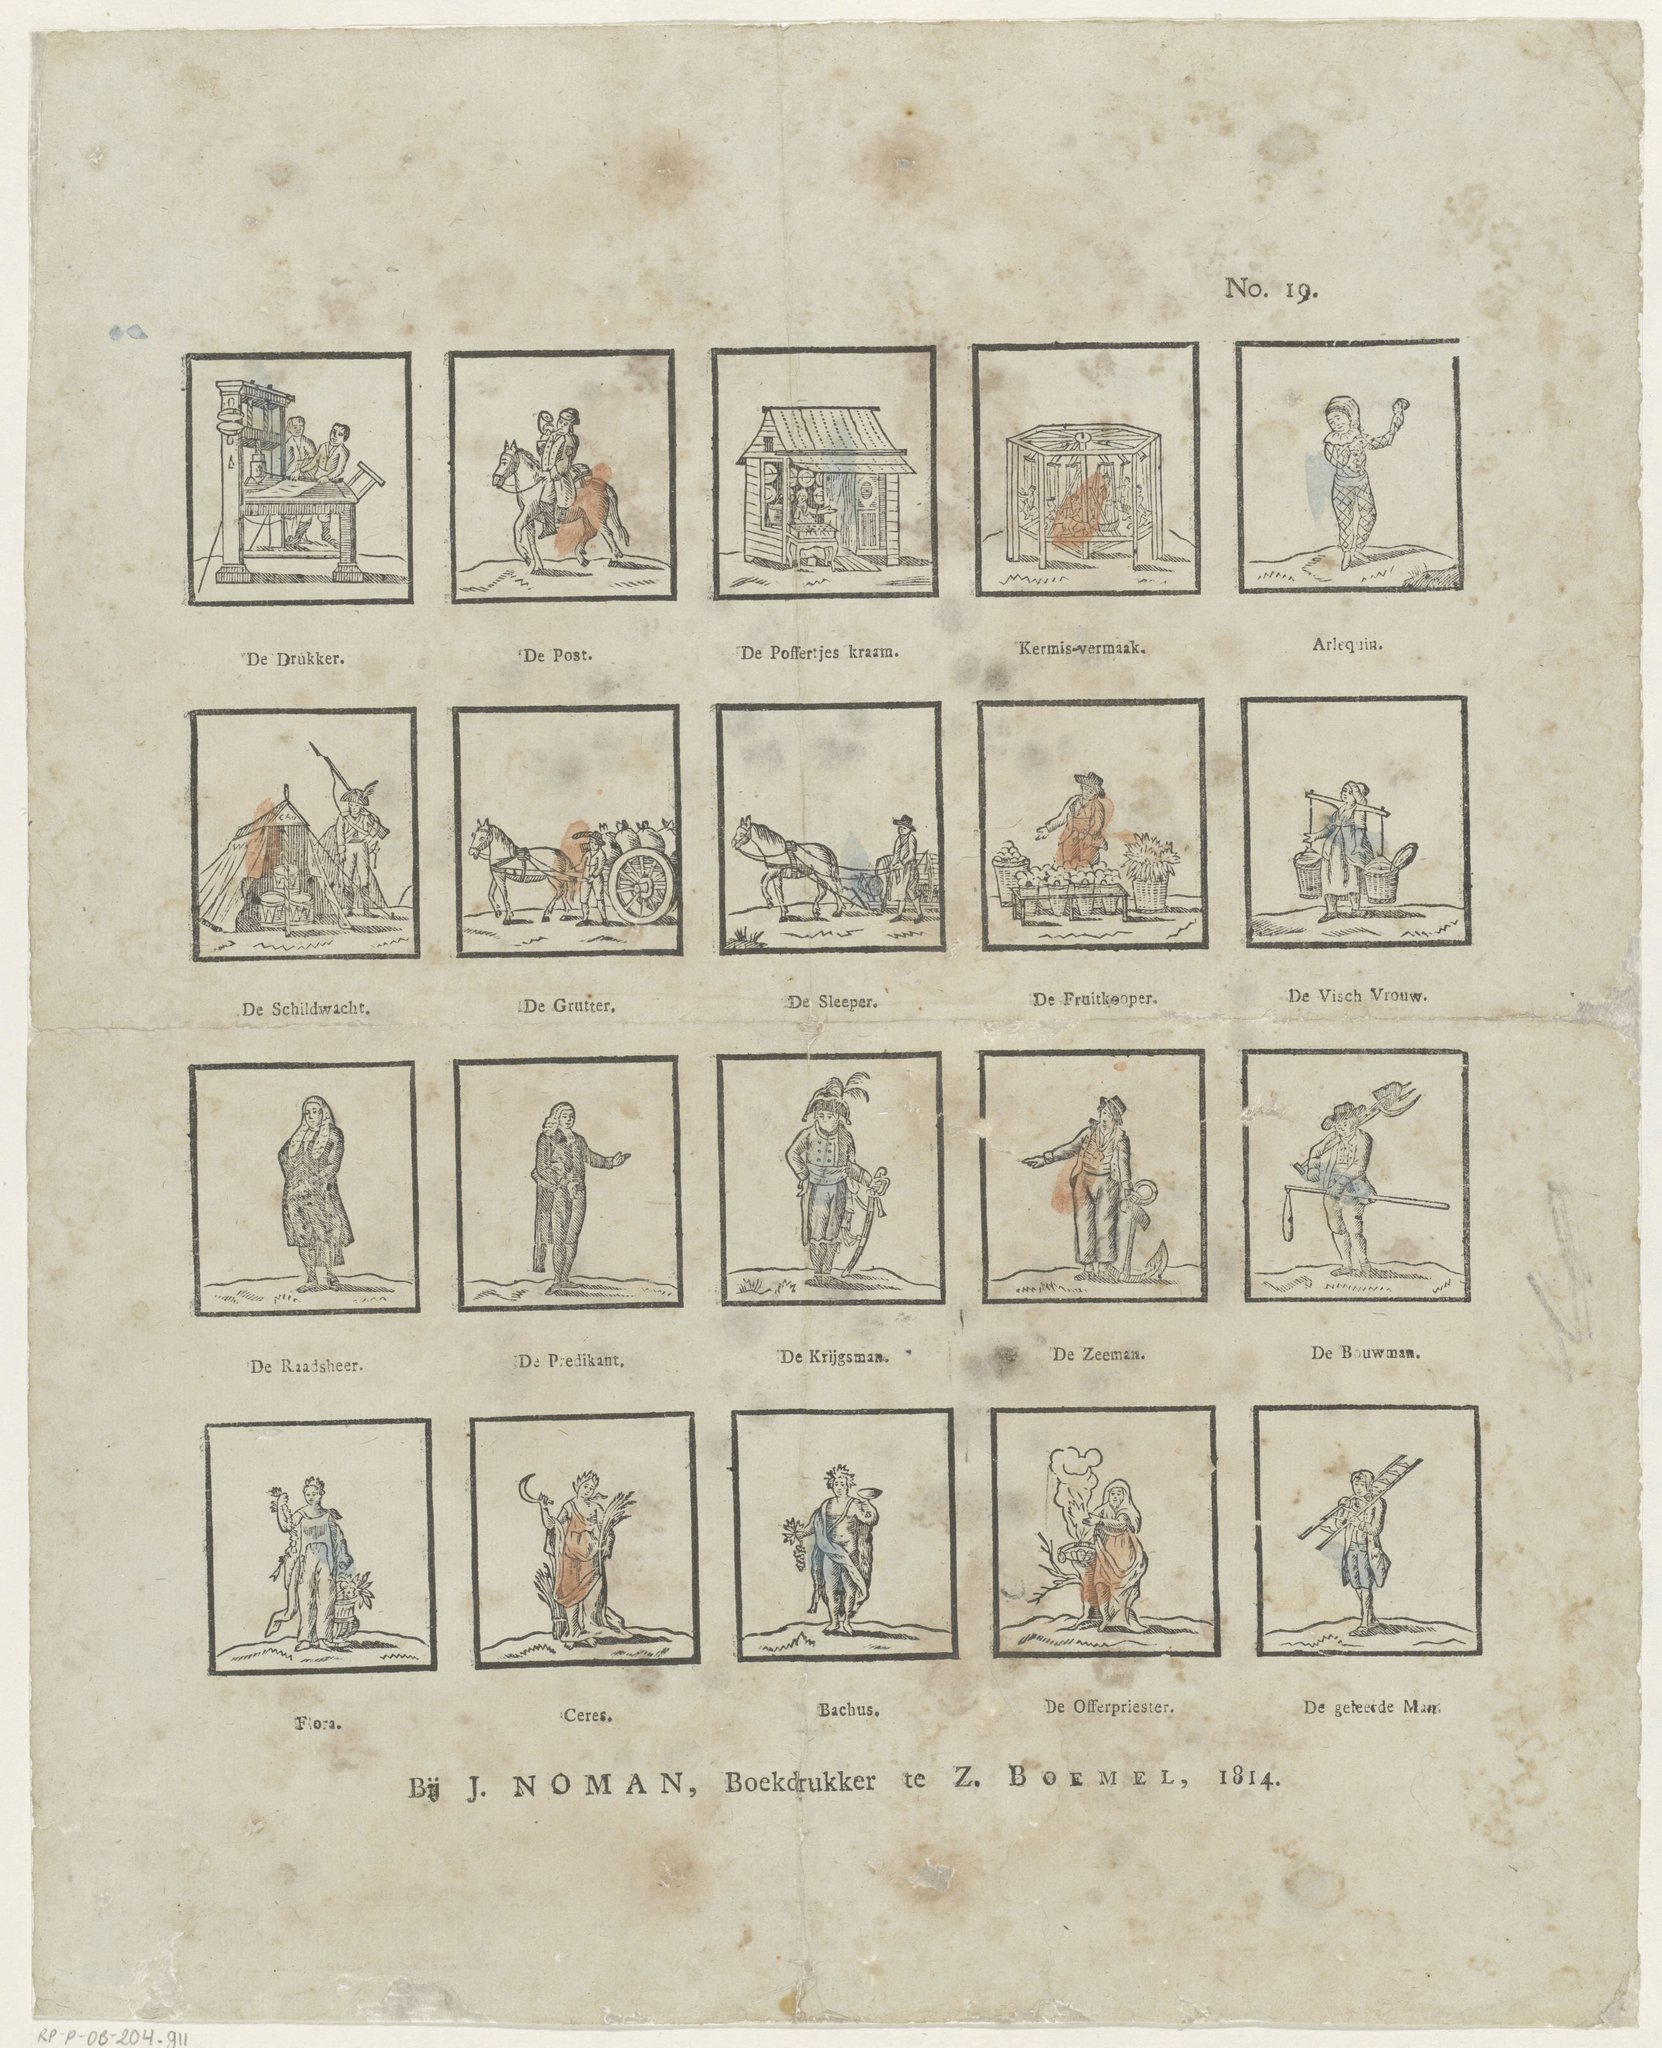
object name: print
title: Figuren en bezigheden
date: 1806-1830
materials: paper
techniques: colour, letterpress printing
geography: netherlands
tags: (story of) ceres (demeter), craft-production, skilled handiwork, human types, working class, labourers, pleasure fair and circus, the soldier; the soldier's life, crafts and industries, (story of) flora, seaman: sailor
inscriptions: collector's mark: Lugt 2760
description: Blad met 20 voorstellingen van verschillende figuren en bezigheden. Onder elke voorstelling een onderschrift. Genummerd rechtsboven: No. 19.